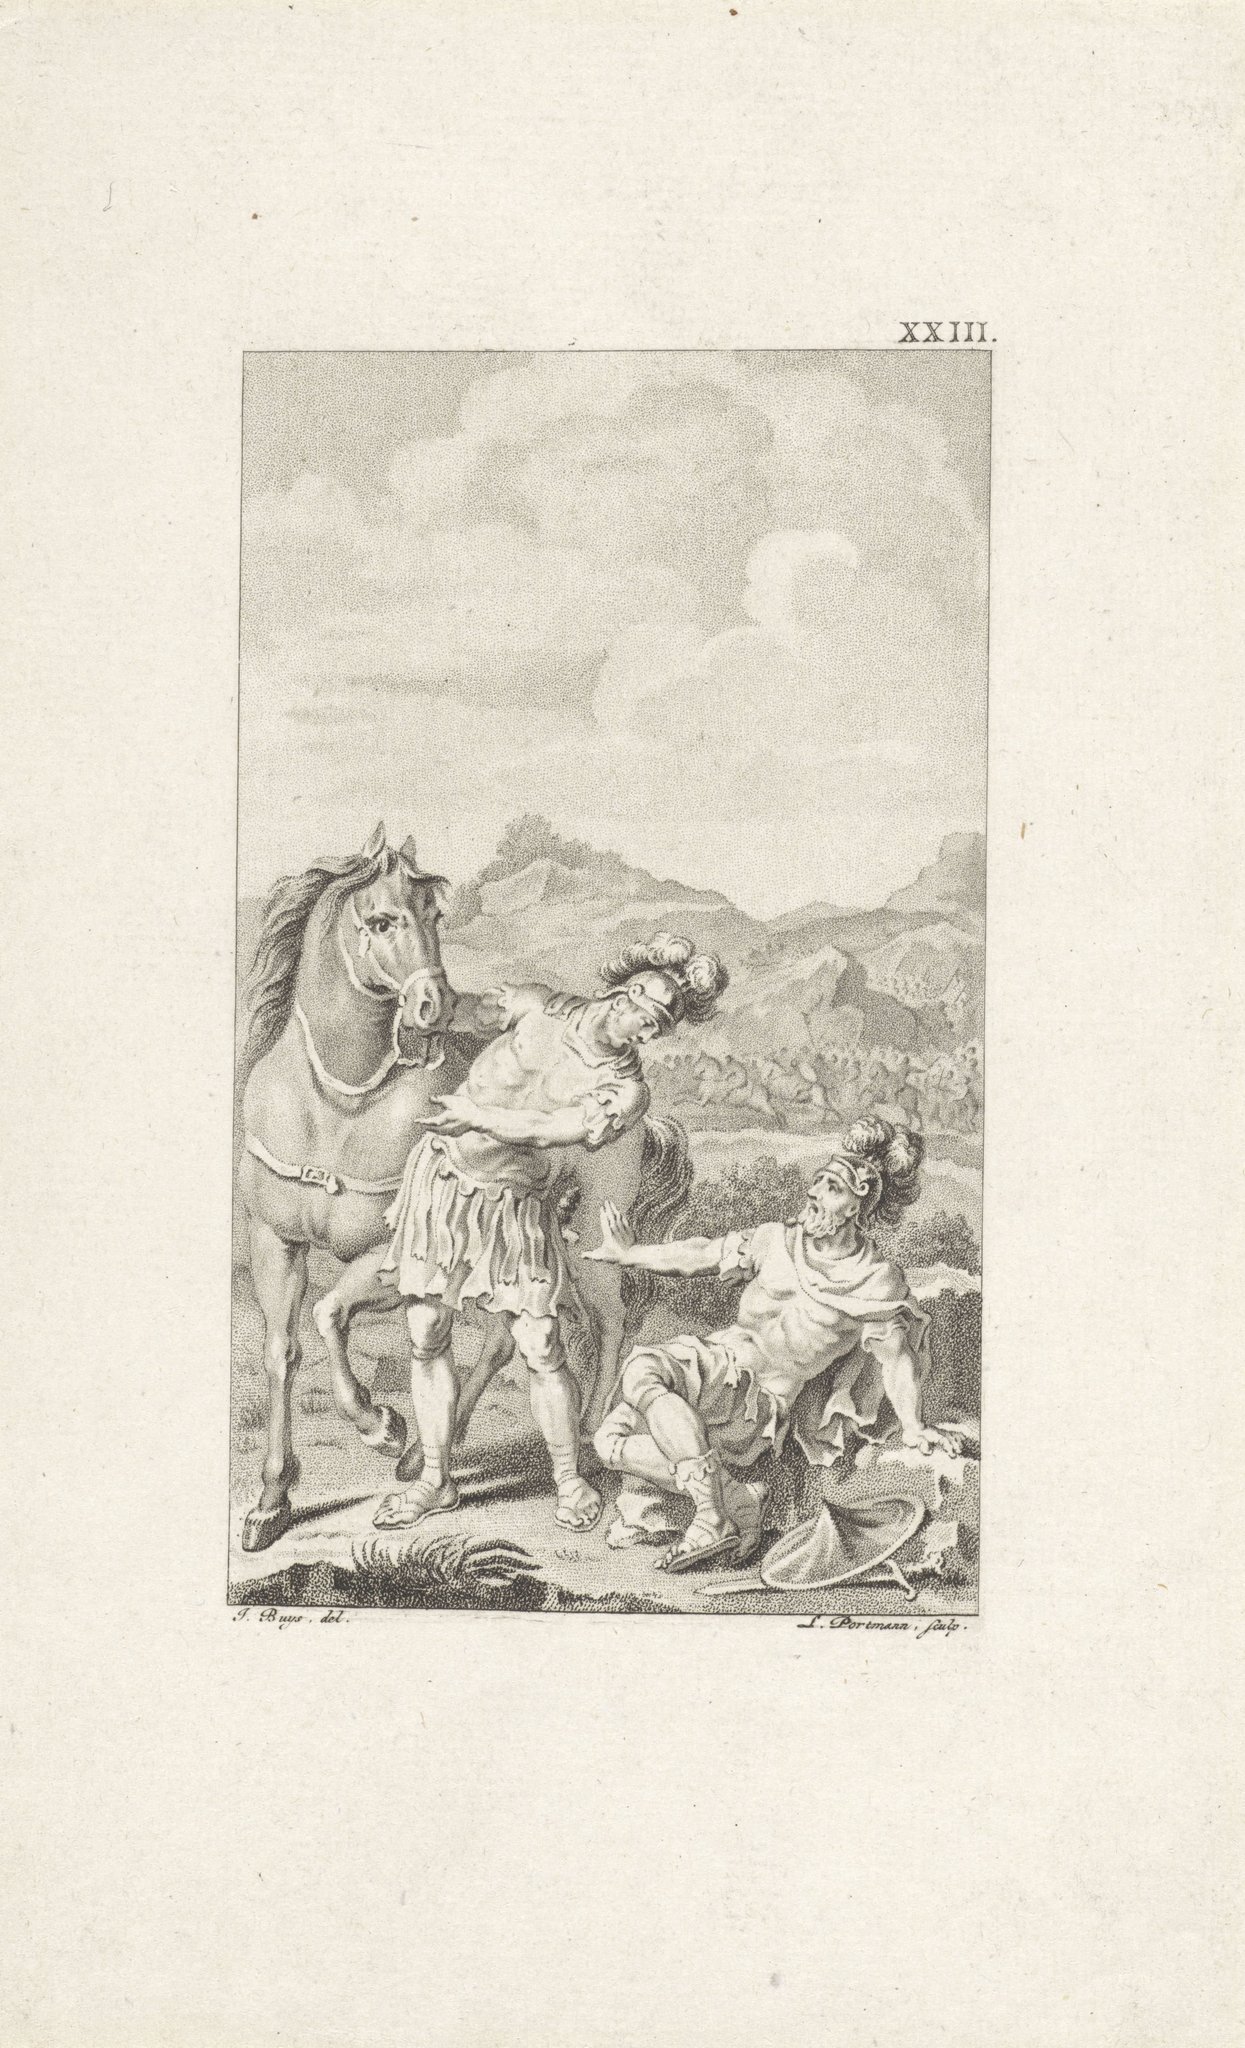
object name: print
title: Dood van Lucius Emilius Paulus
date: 1795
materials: paper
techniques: stippled etching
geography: amsterdam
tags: (story of) lucius aemilius paul(l)us - death of person from classical history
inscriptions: collector's mark: Lugt 2228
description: Een Romeinse soldaat die wegvlucht voor de vijand ziet de stervende Lucius Emilius Paulus liggen. Hij biedt hem zijn paard aan. Lucius Emilius Paulus weigert echter en draagt de soldaat op zelf weg te vluchten.